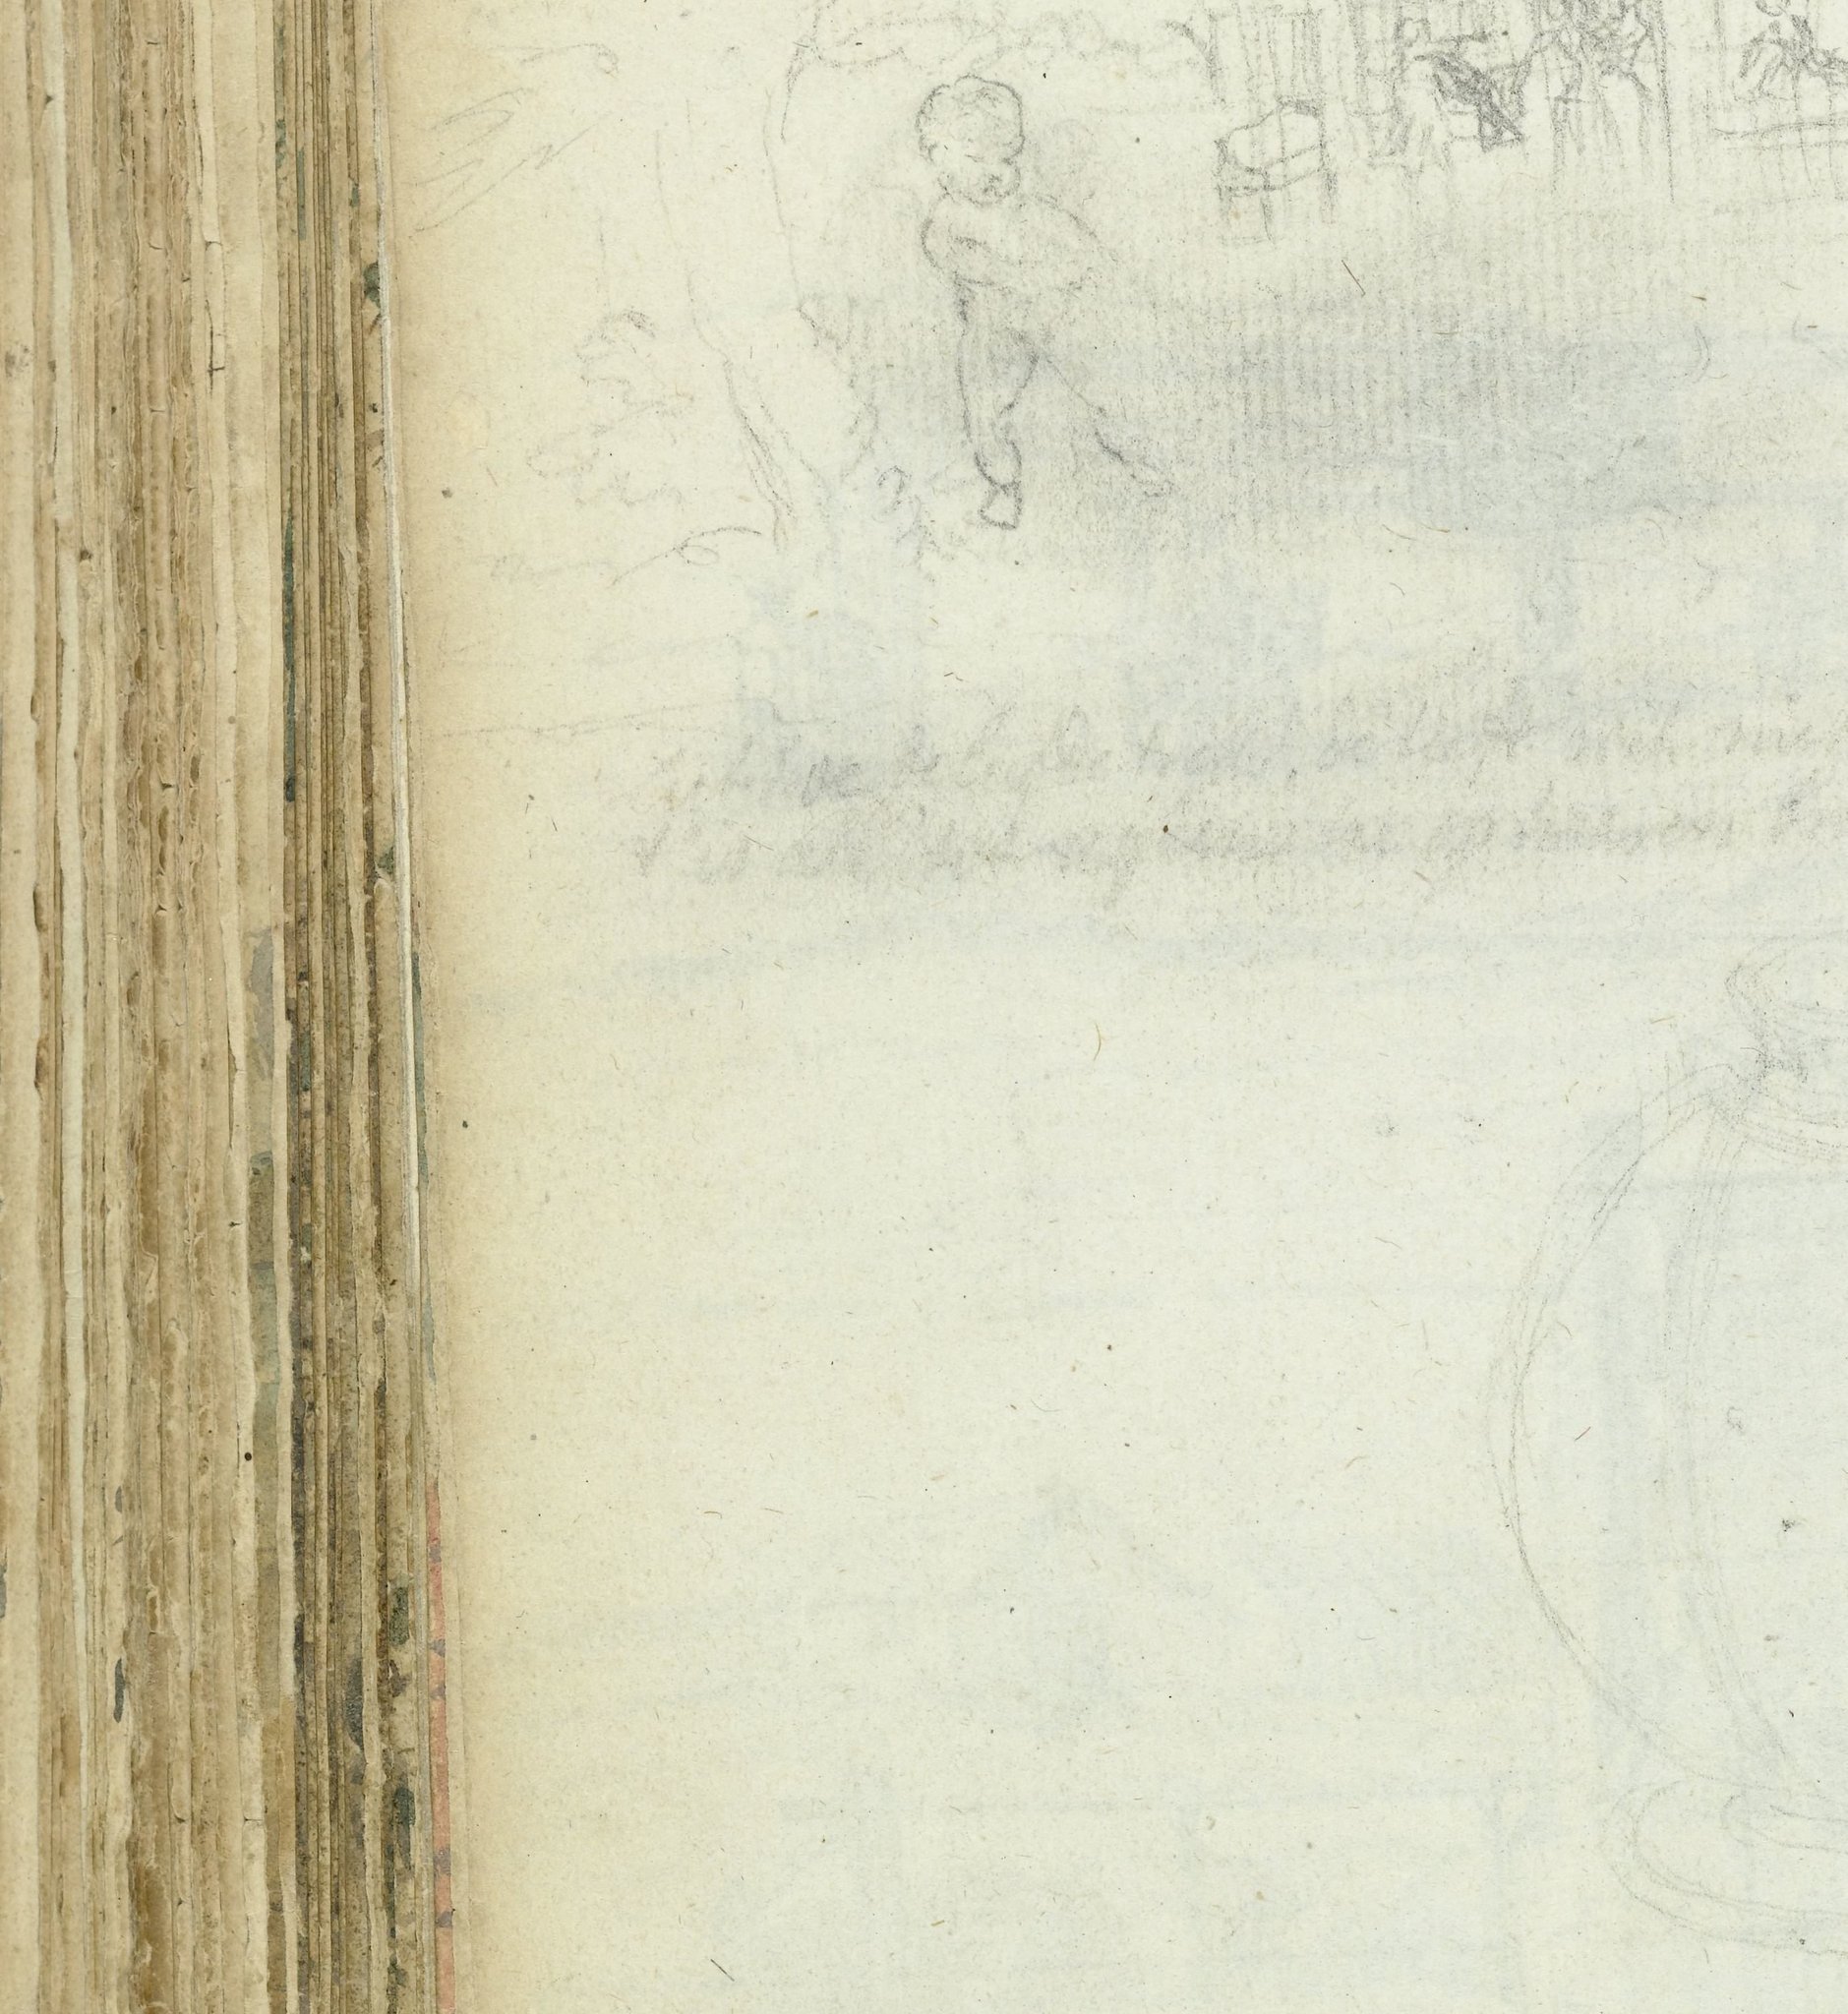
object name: drawing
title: Kind voor een huis. Een pot.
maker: jan brandes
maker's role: draughtsman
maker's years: 1743-1808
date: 1770-1808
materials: paper, pencil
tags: child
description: Potloodschetsen van een kind naast een boom voor een plein met huizen. Een pot. Met opschrift. Onderdeel uit het schetsboek van Jan Brandes, dl. 2 (1808), p. 156.